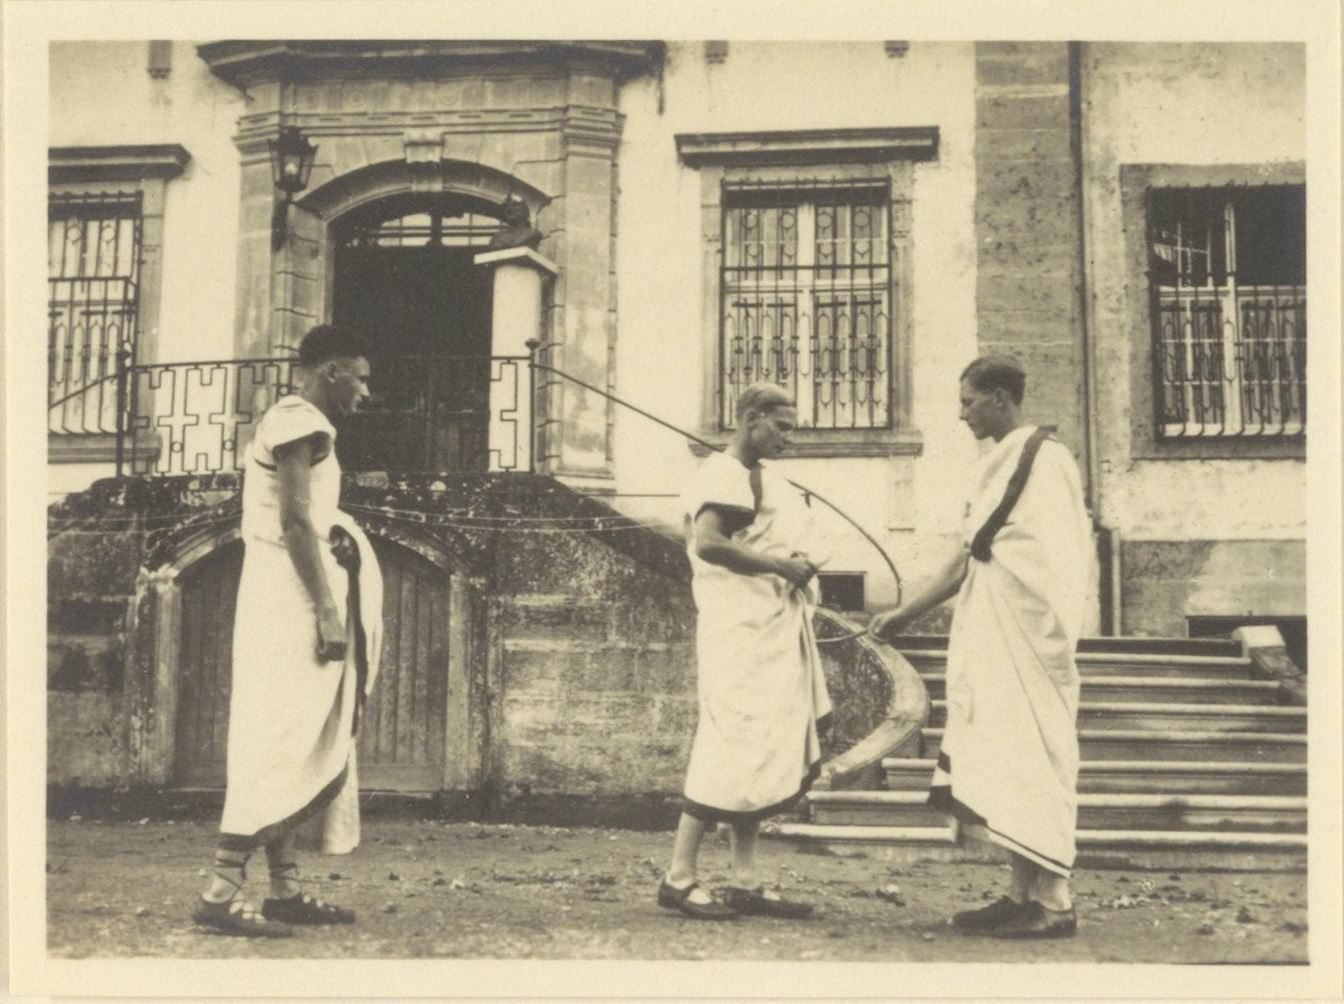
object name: photograph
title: Leerlingen van Schule Schloss Salem tijdens een dramatische uitvoering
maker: Anonymous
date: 1929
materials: photographic support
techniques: gelatin silver print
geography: salem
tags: performance, theatre, theatrical performance, historical costume, education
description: Onderdeel van Fotoalbum van Schule Schloss Salem.